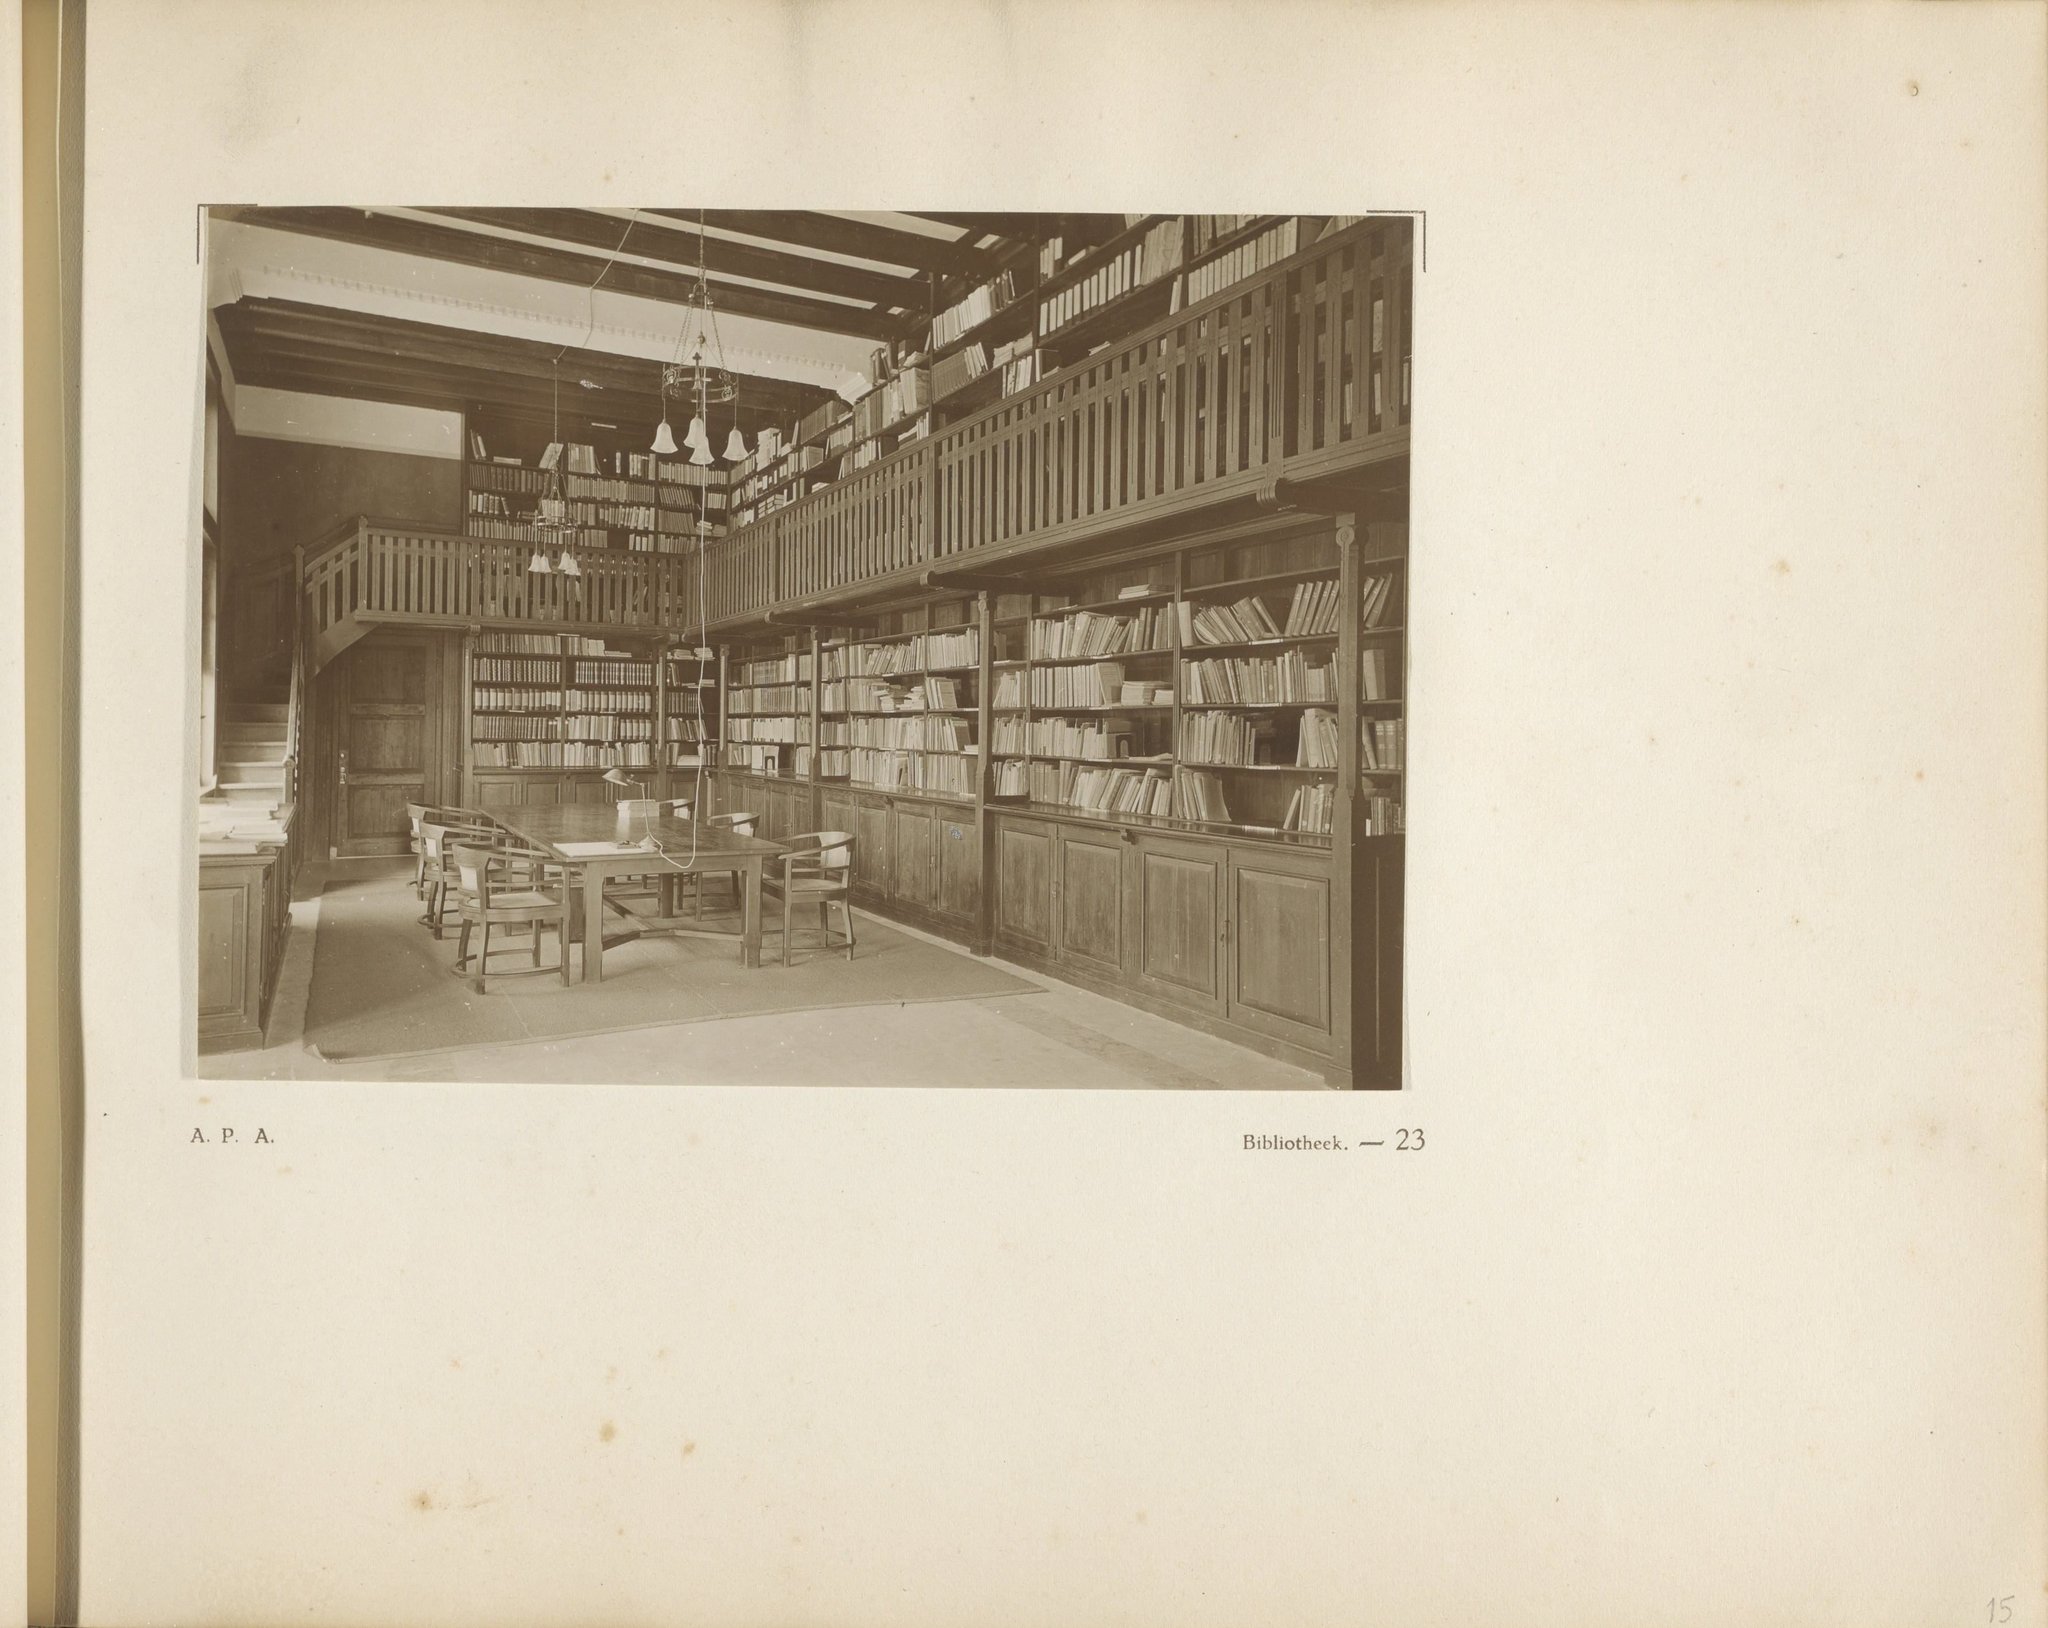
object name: photograph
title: Pagina 23 van fotoboek van de Algemeene Vereeniging van Rubberplanters ter Oostkust van Sumatra (A.V.R.O.S.)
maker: j.w. meyster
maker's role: fotograaf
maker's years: 1887-1945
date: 1924-1925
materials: paper, photographic support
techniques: printing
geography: sumatra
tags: (non-fruit) products of plants or trees: rubber, laboratory, public library, sumatra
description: Boekpagina met een foto van het interieur van de bibliotheek van het Algemeen Proefstation van de Algemeene Vereeniging van Rubberplanters ter Oostkust van Sumatra (A.V.R.O.S.) te Kampong Baroe. Onderdeel van een fotoboek van de Algemeene Vereeniging van Rubberplanters ter Oostkust van Sumatra (A.V.R.O.S.).